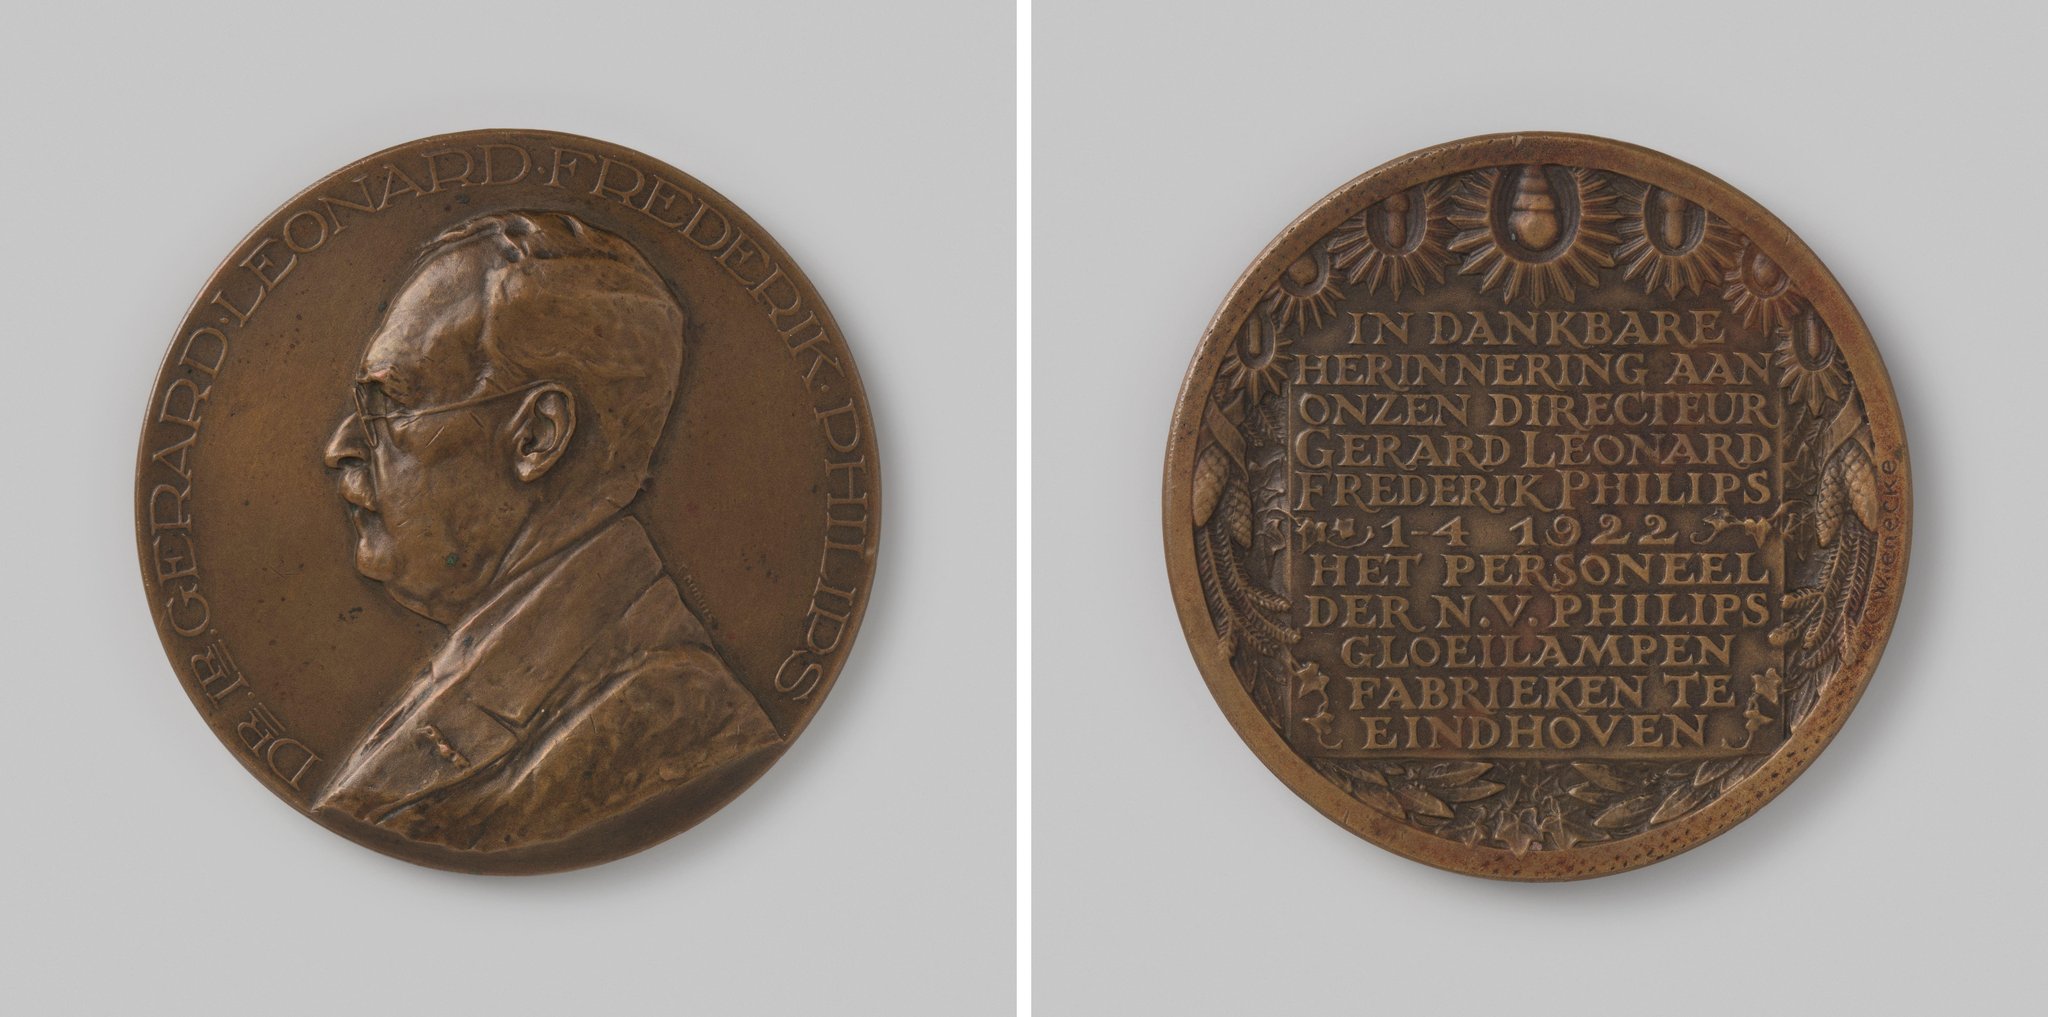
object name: history medal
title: Aftreden van Gerard Philips als directeur van de Philips Gloeilampenfabriek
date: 1922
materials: bronze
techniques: striking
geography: netherlands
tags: philips nv, industrieel, gerard leonard frederik philips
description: Aftreden van Gerard Philips als directeur van de Philips Gloeilampenfabriek. Bronzen penning, voorzijde: portret (borstbeeld) van man (Gerard Philips), en profil naar links, binnen omschrift; keerzijde: elfregelige tekst binnen krans van onder meer gloeilampen, dennentakken.